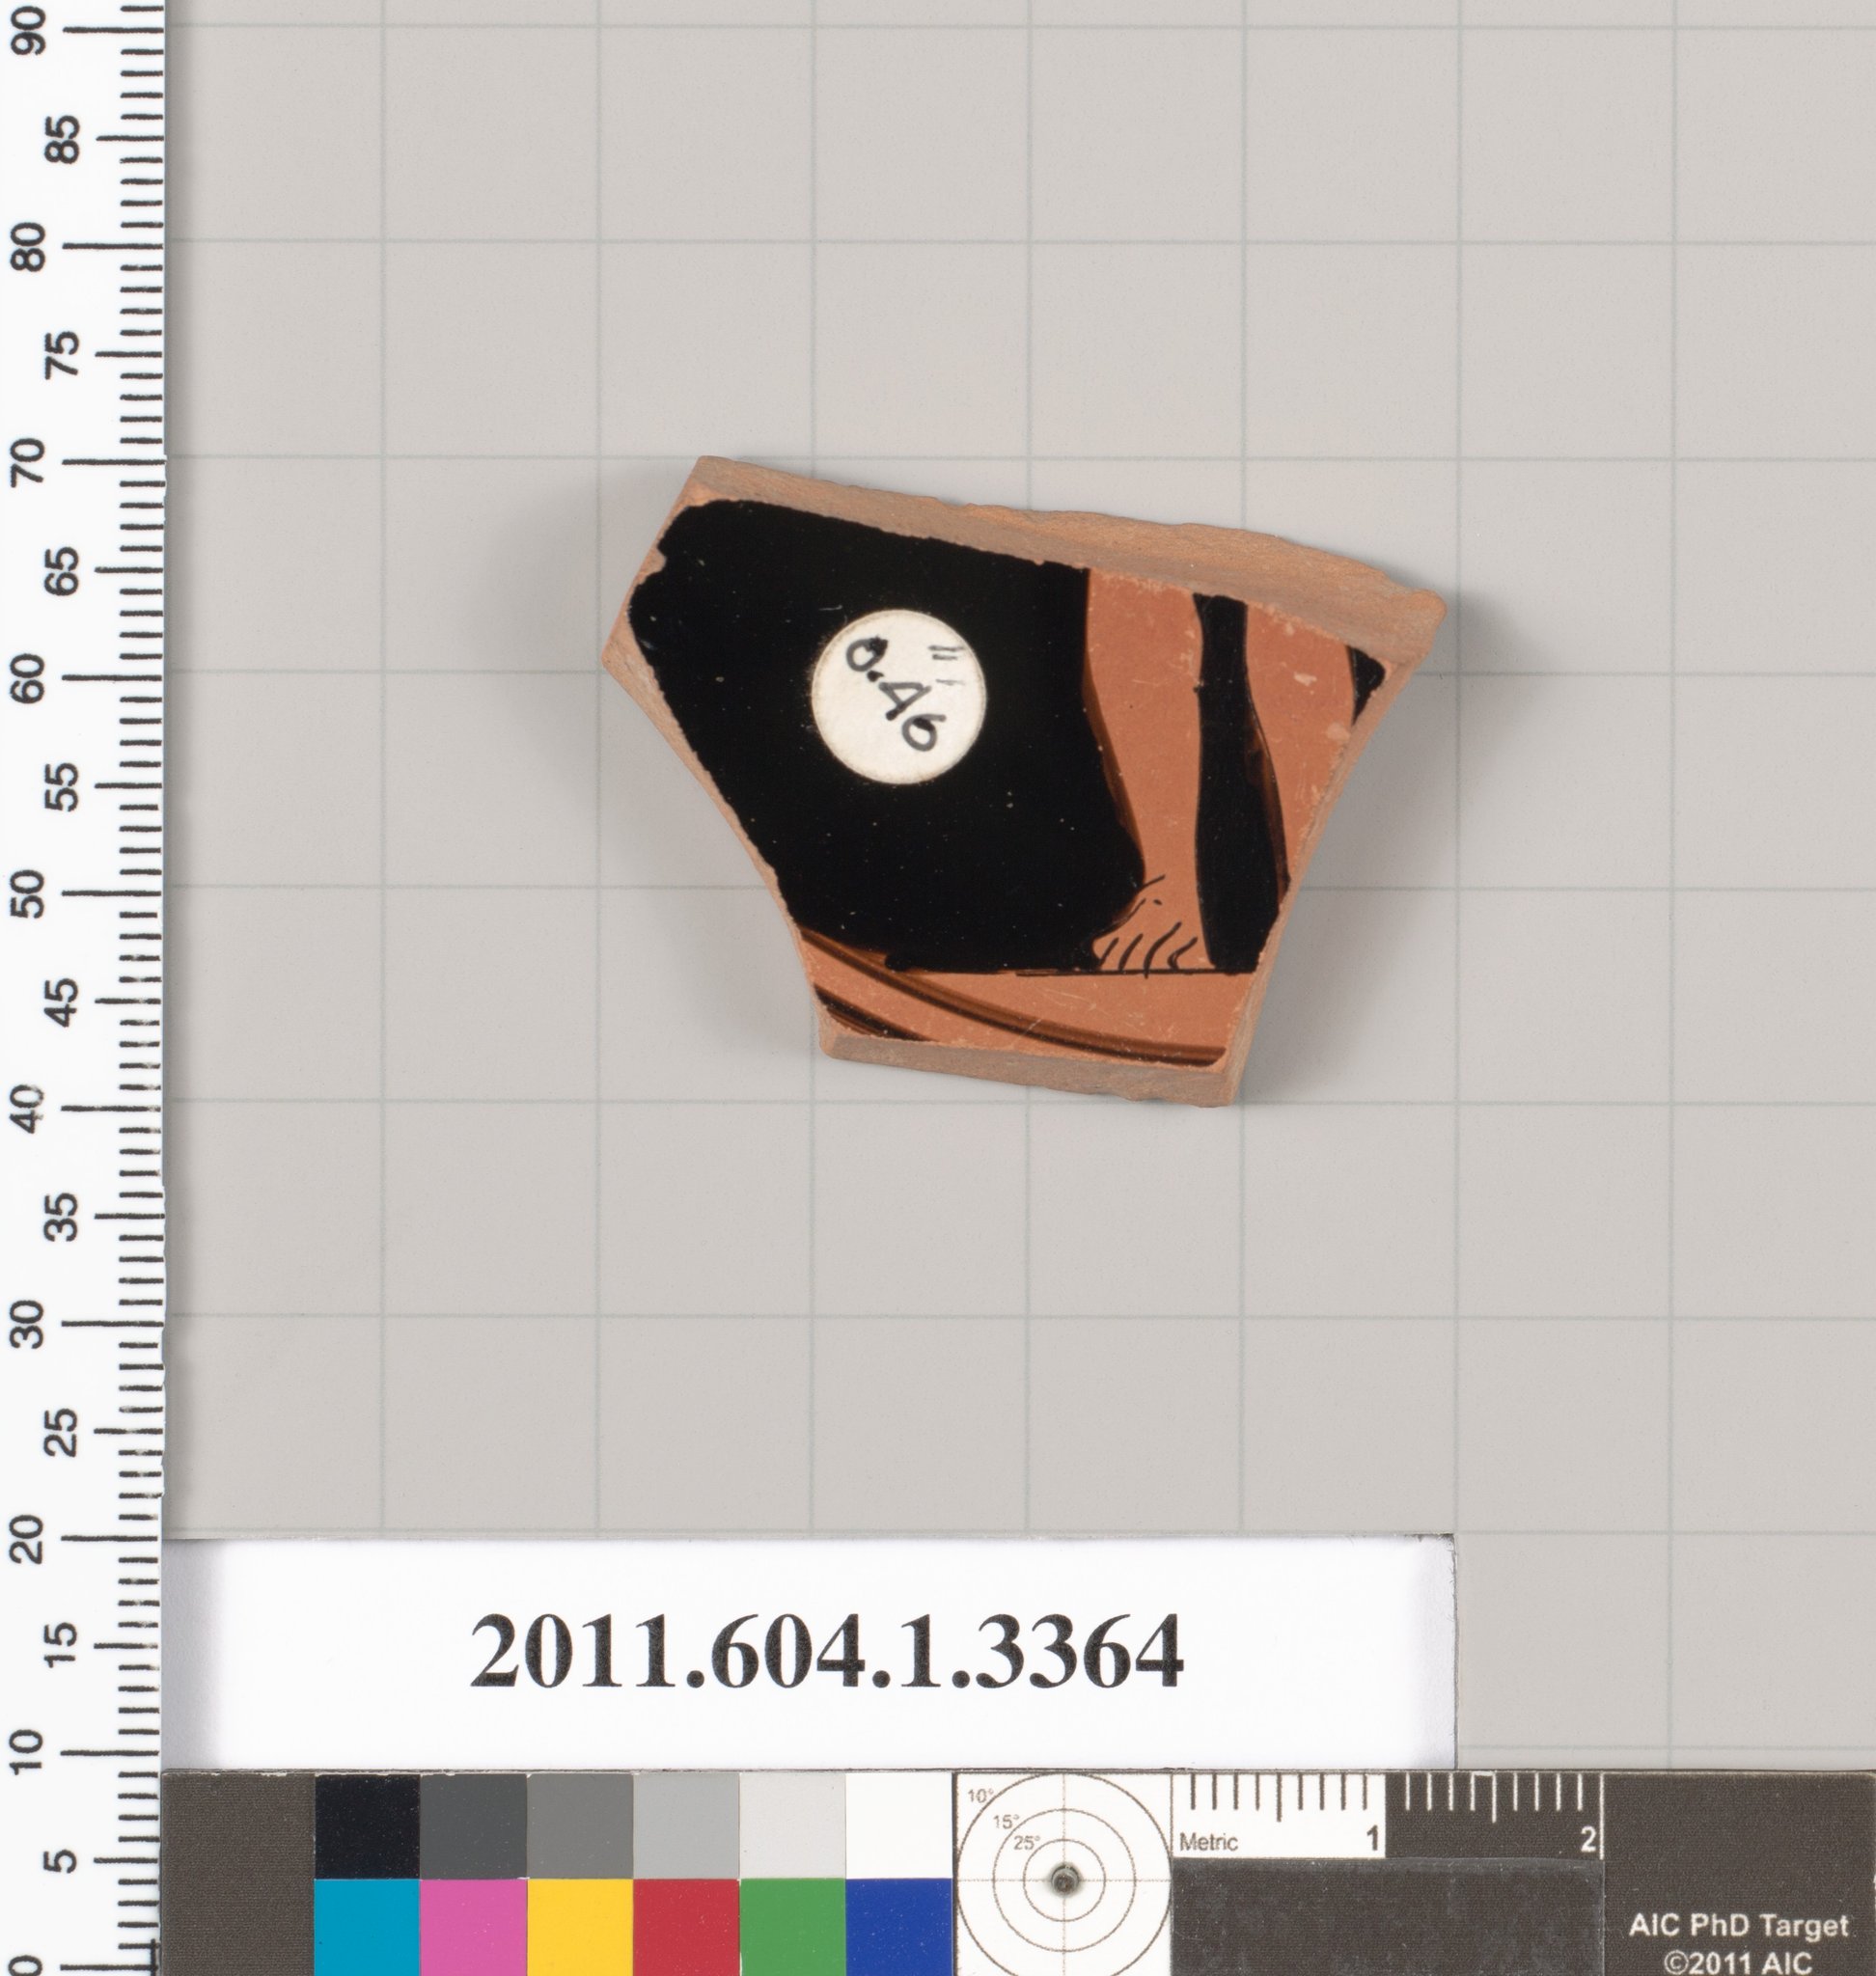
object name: kylix fragment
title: Terracotta fragment of a kylix (drinking cup)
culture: greek, attic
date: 475-451 BCE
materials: terracotta